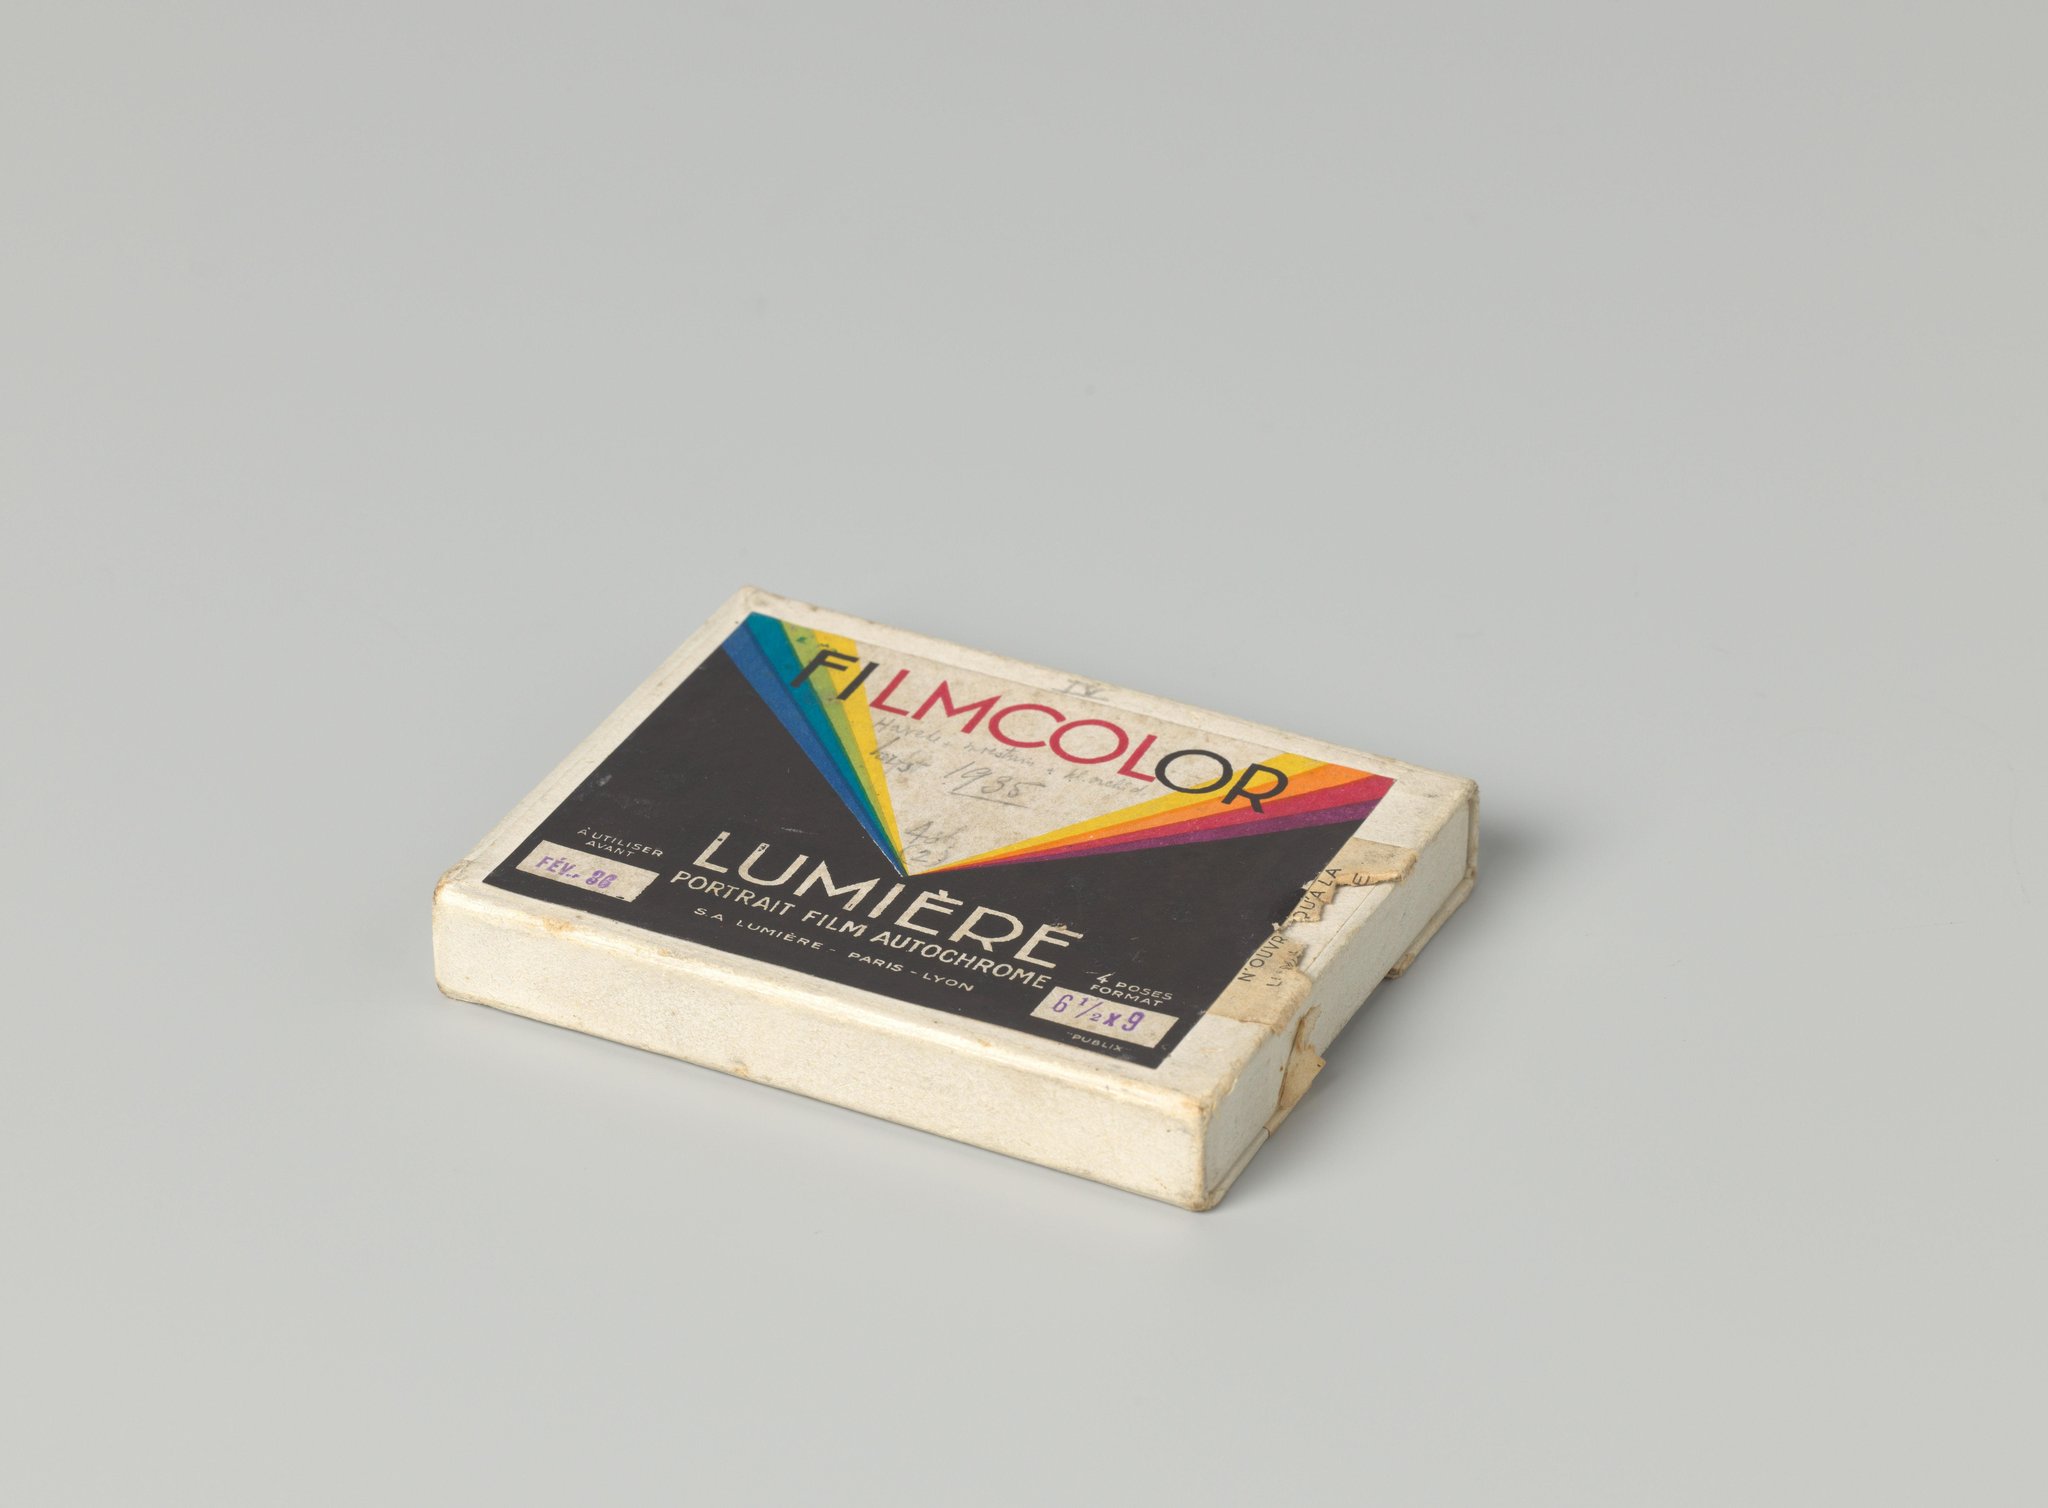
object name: box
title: Doos voor autochromes van Lumière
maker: lumière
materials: cardboard, paper, tape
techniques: printing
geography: france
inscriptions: date: ‘À UTILISER/ AVANT/ FÉV. 36’, inscription: ‘IV/ [...]/ 1935/ 4st/ (2)’